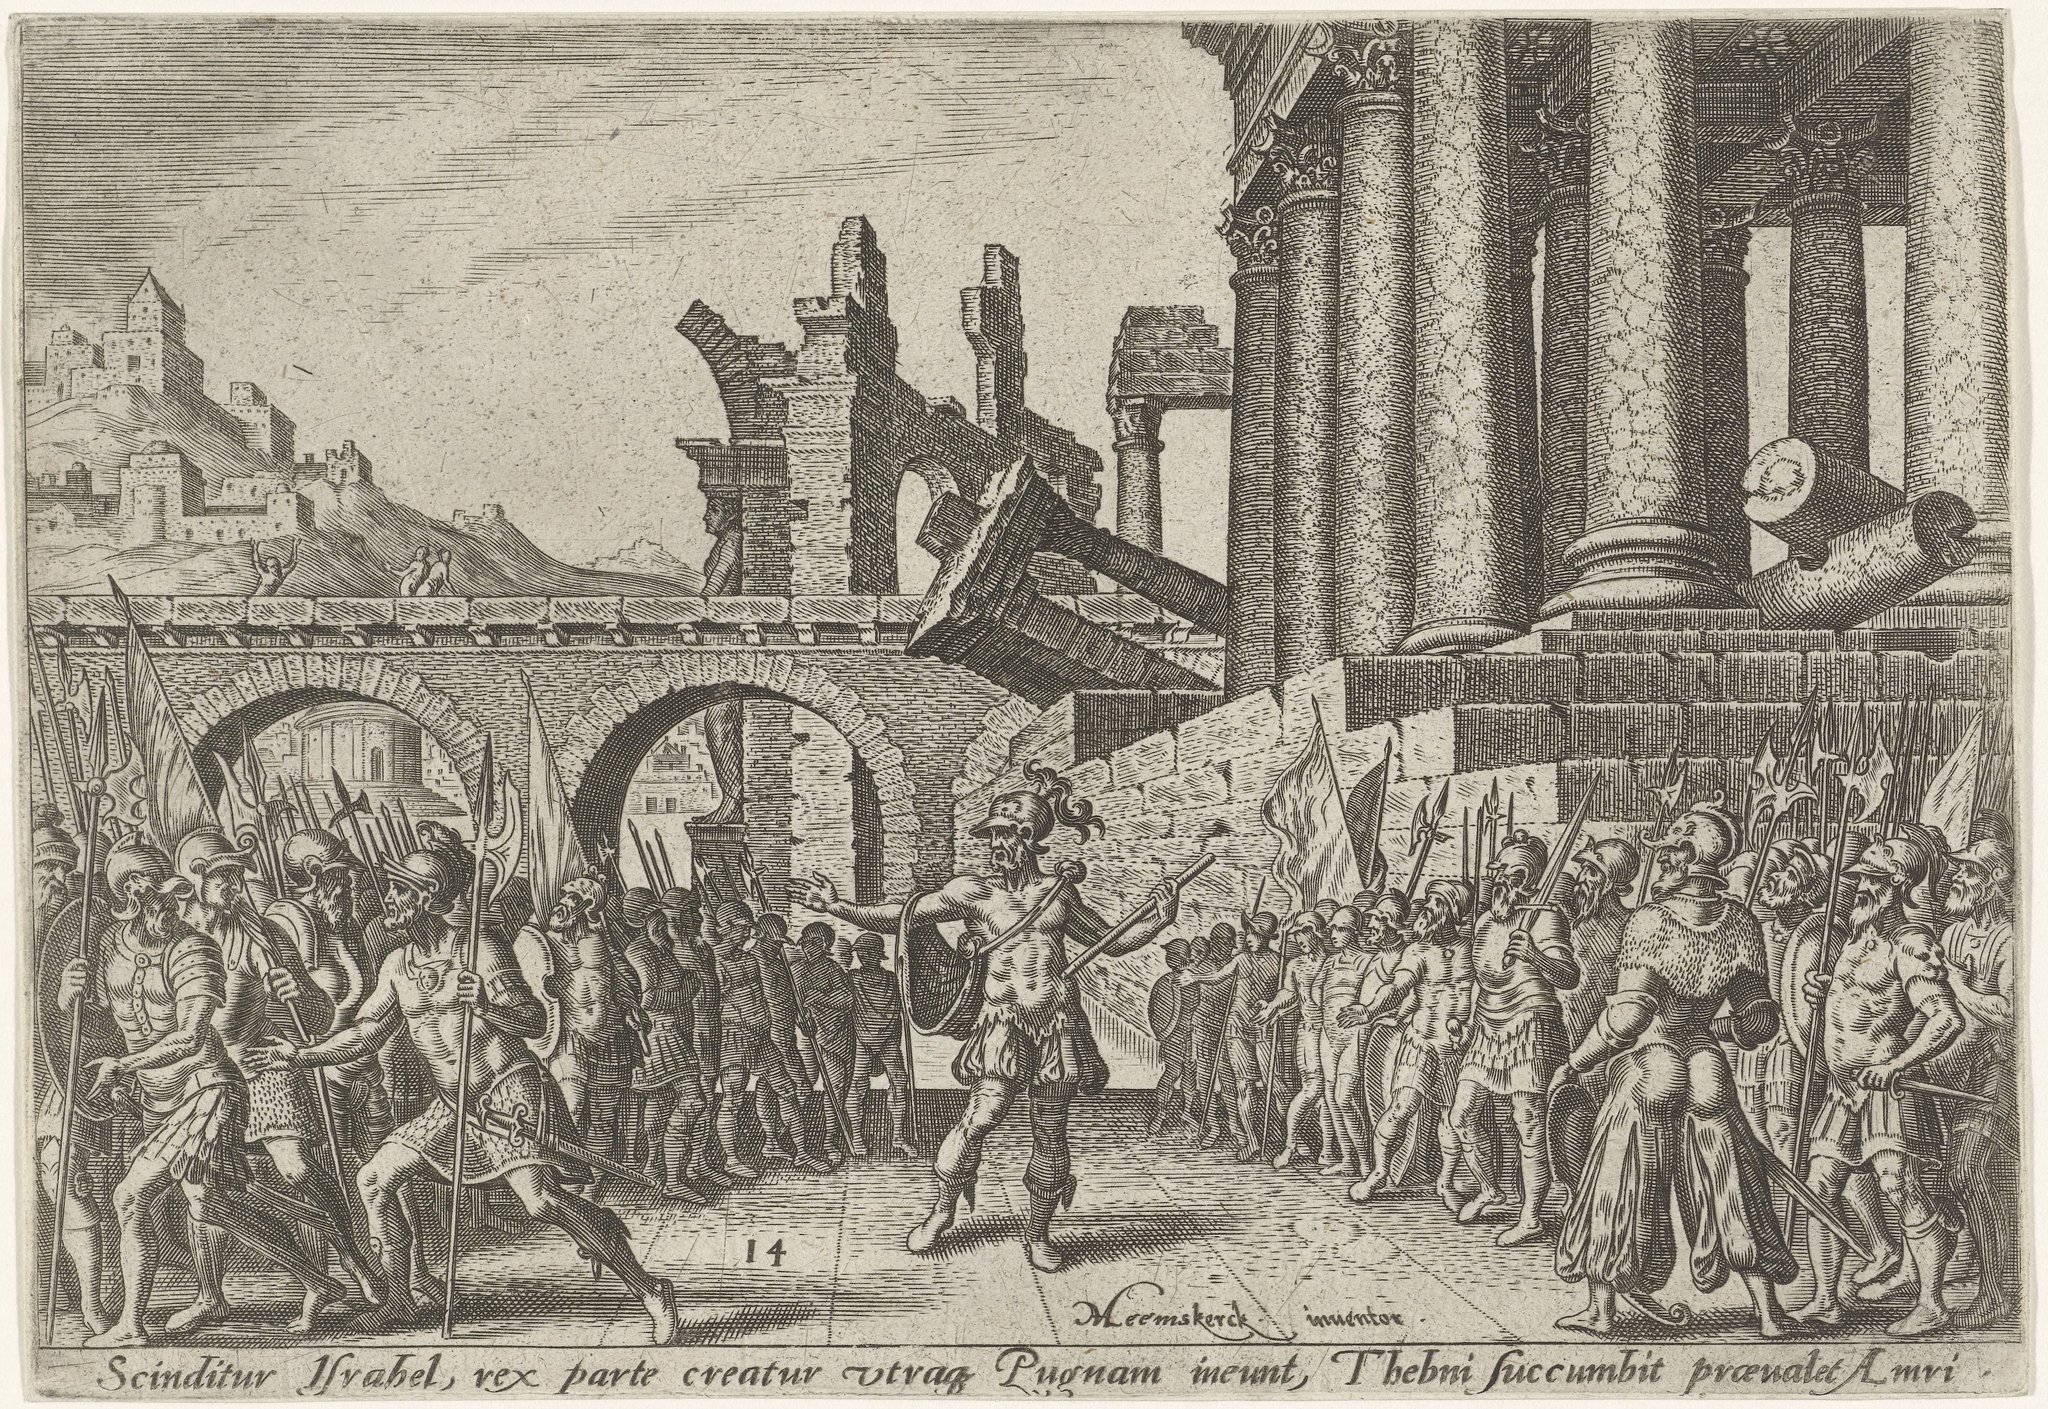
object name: print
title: De onheilsdagen van het Joodse volk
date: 1569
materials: paper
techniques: engraving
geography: haarlem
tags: the people of israel are divided; some want tibni as king, others want omri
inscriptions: caption: ‘Scinditur Israhel, rex parte creatur utraq[ue]...praevalat Amri.’, number: ‘14’, signature: ‘MHeemskerck inventor’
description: Het ene deel van het volk wil Tibni als koning, het andere deel is voor Omri. Voor de tempel en verwoeste stad wordt het volk verdeeld in twee groepen.